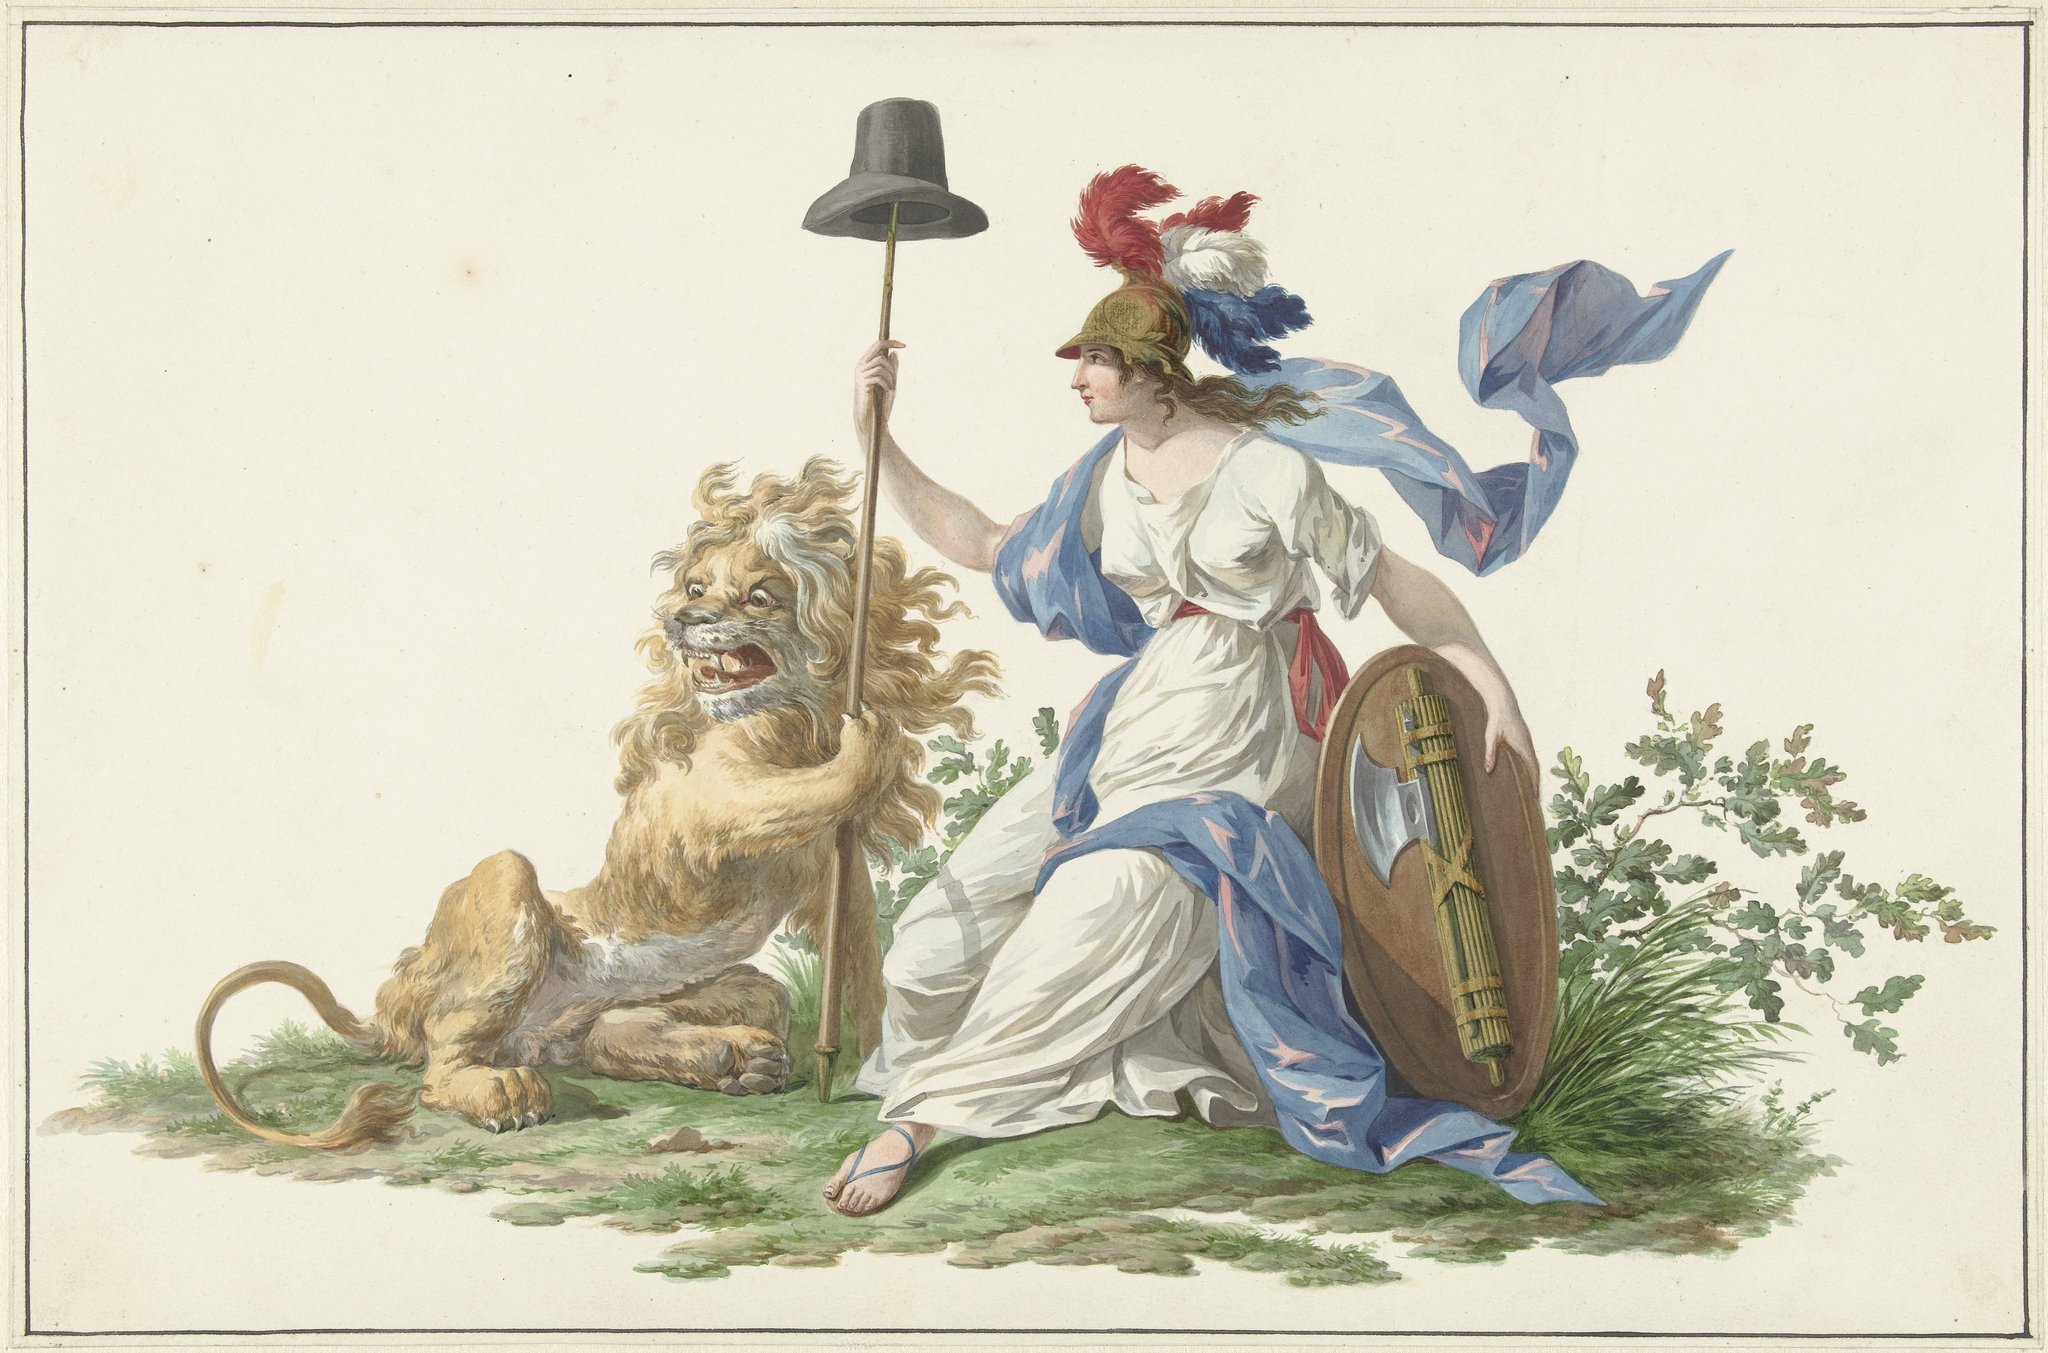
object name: watercolor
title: Model voor de vlag van de Bataafse Marine, 1796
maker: dirk langendijk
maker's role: draughtsman, painter, print maker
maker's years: 1748-1805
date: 1796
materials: paint, paper, pencil, watercolor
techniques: brush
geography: netherlands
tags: (military) flags and standards (+ naval force), personifications of countries, nations, states, districts, etc., beasts of prey, predatory animals: lion, netherlands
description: Ontwerp voor het allegorisch embleem dat voor de vlag van de Marine van de Bataafse Republiek toegevoegd wordt aan de linker bovenhoek van de bestaande vlag van de Bataafse Republiek, ingaande 1 maart 1796. Embleem waarin de Nederlandse Maagd en de Nederlandse Leeuw samen een speer met de vrijheidshoed vasthouden.